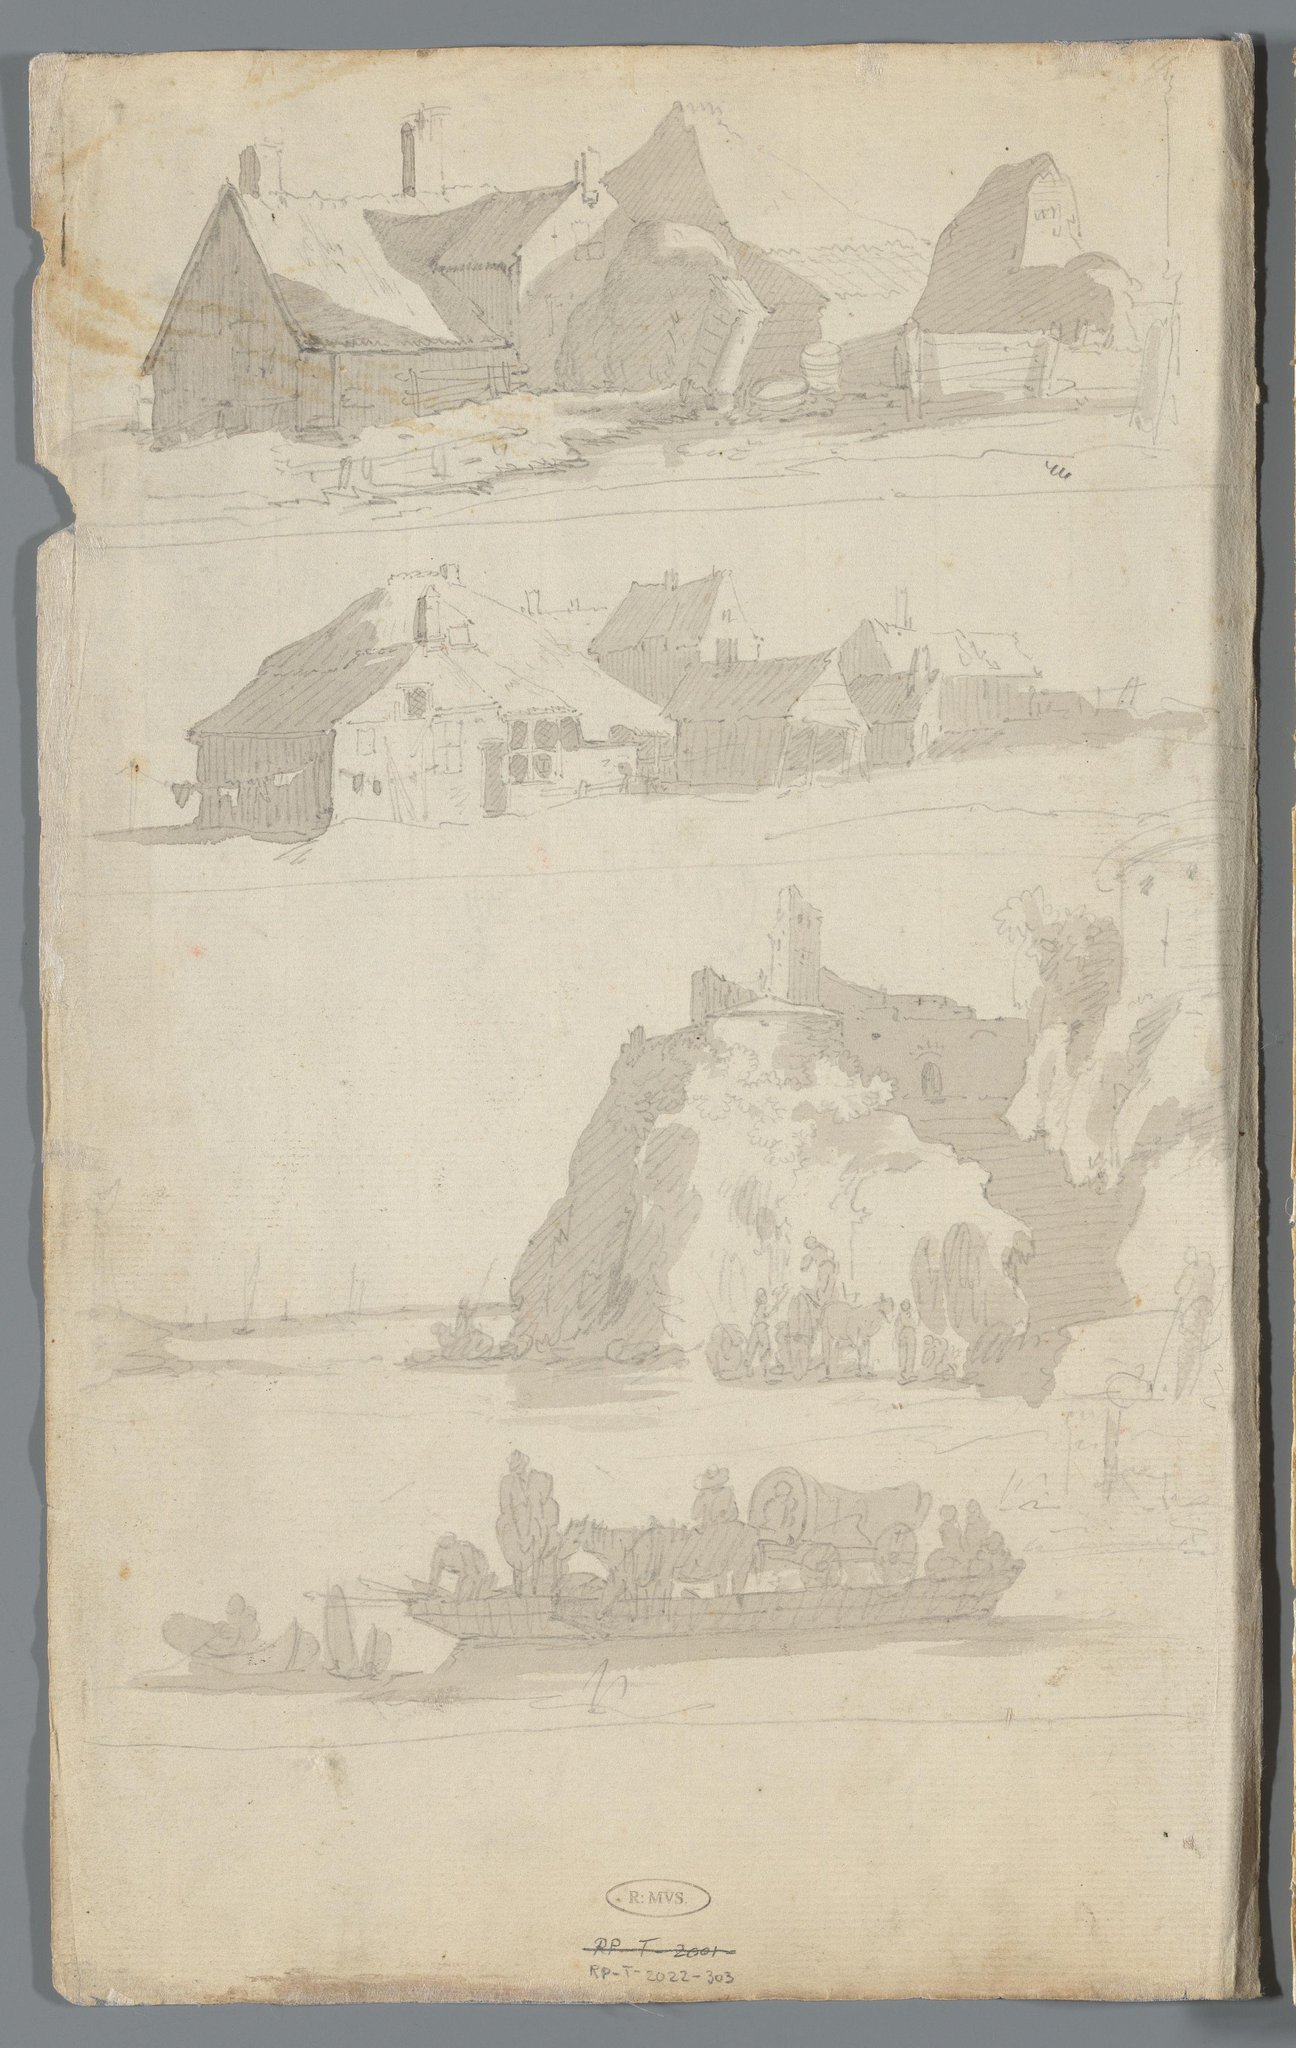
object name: sketchbook leaf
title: Boerderijen en een schuit met vee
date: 1780-1800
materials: ink, paper, pencil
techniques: brush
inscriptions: inscription: ‘RP-T-2001-’, collector's mark: ‘L.2228’